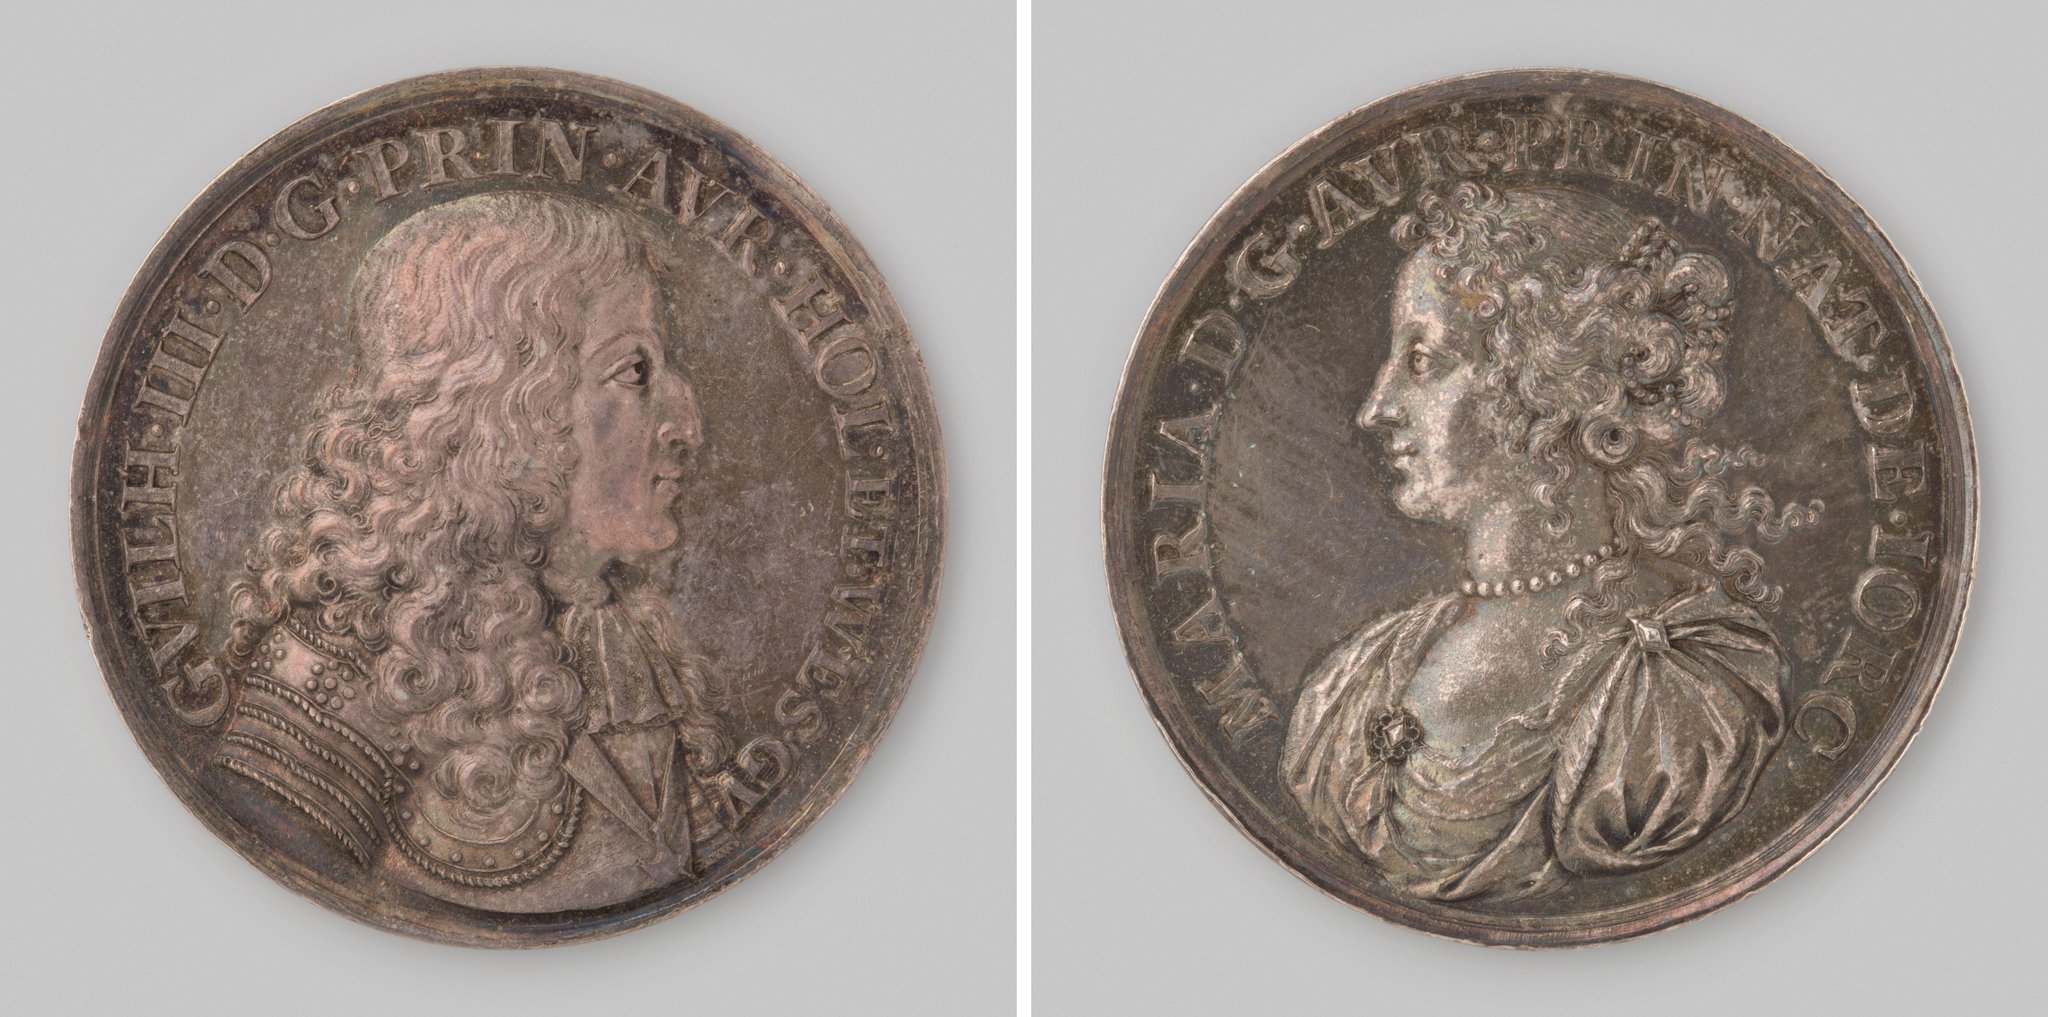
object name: history medal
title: Huwelijk Stadhouder Willem III met Maria van York 1677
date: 1677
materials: silver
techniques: striking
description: Zilveren penning, op de voorzijde het geharnaste borstbeeld van Willem III naar rechts, met omschrift, op de keerzijde het borstbeeld van Maria naar links, met omschrift.